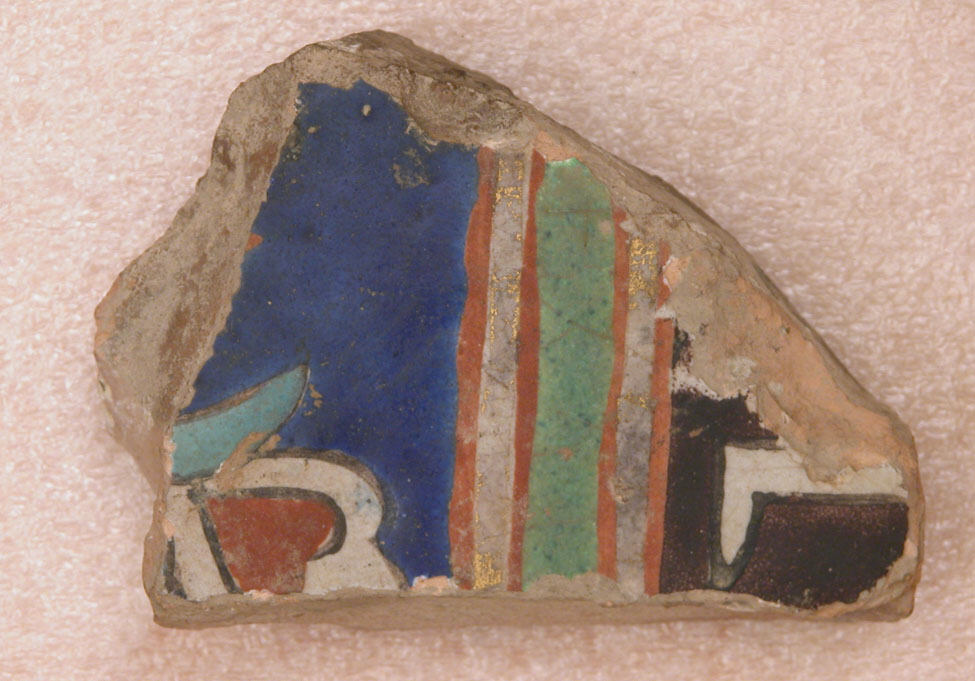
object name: tile fragment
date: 1334-1434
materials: glaze, stonepaste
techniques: painting, polychrome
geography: uzbekistan